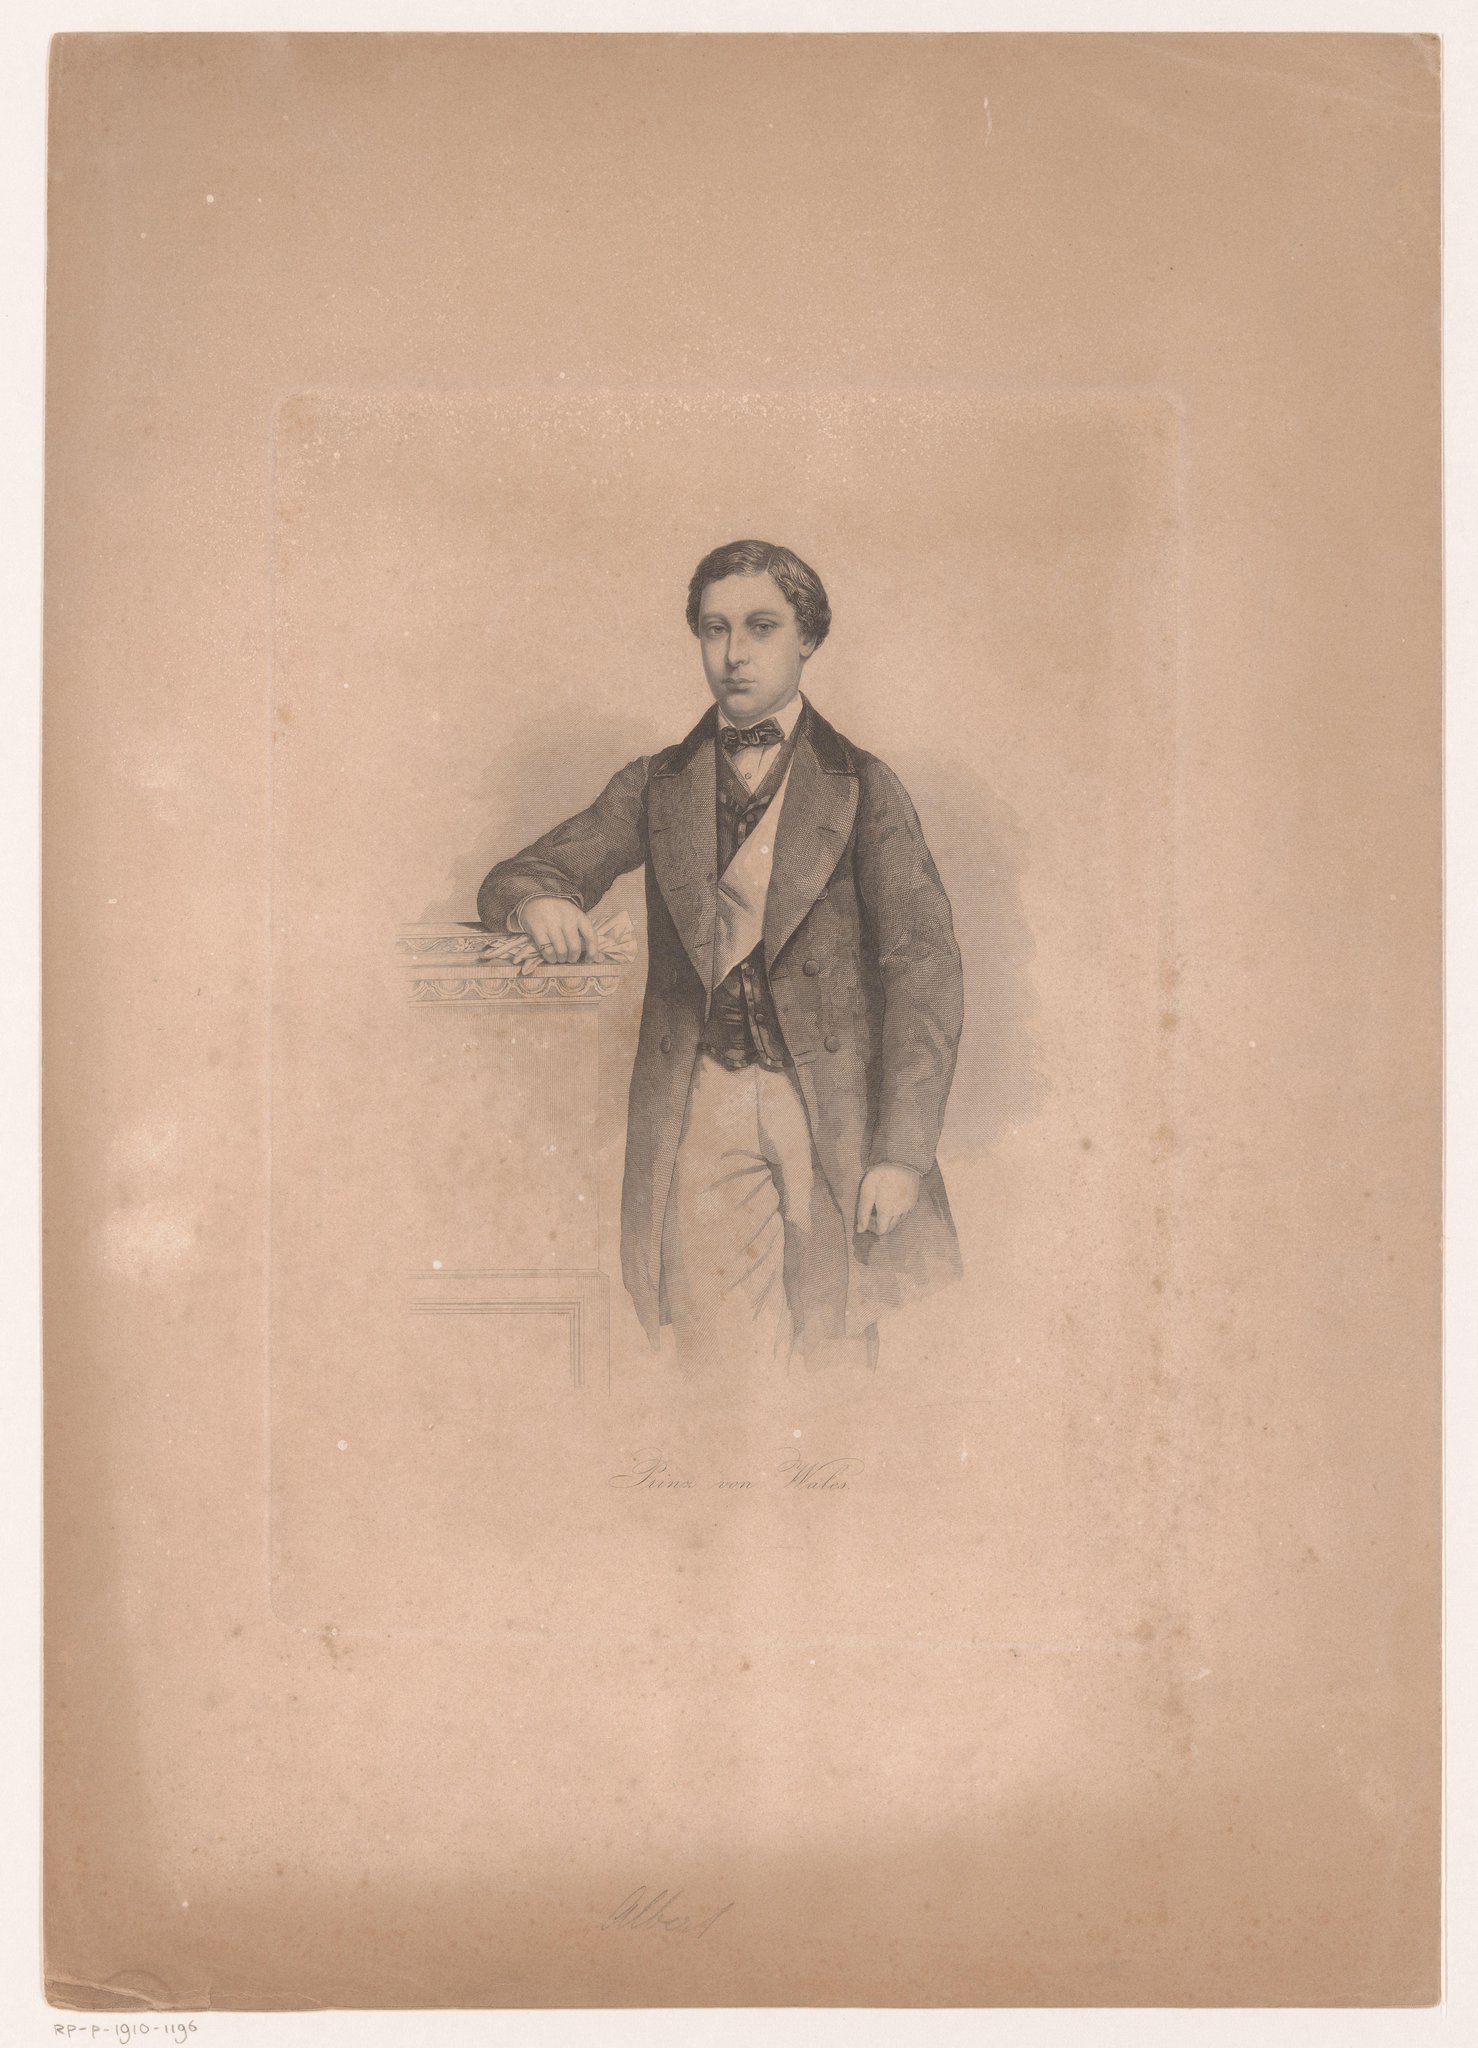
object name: print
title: Portret van Edward VII, koning van het Verenigd Koninkrijk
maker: august weger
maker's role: print maker, printer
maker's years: 1823-1892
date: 1865-1892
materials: paper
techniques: engraving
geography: leipzig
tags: historical persons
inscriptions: collector's mark: Lugt 2228